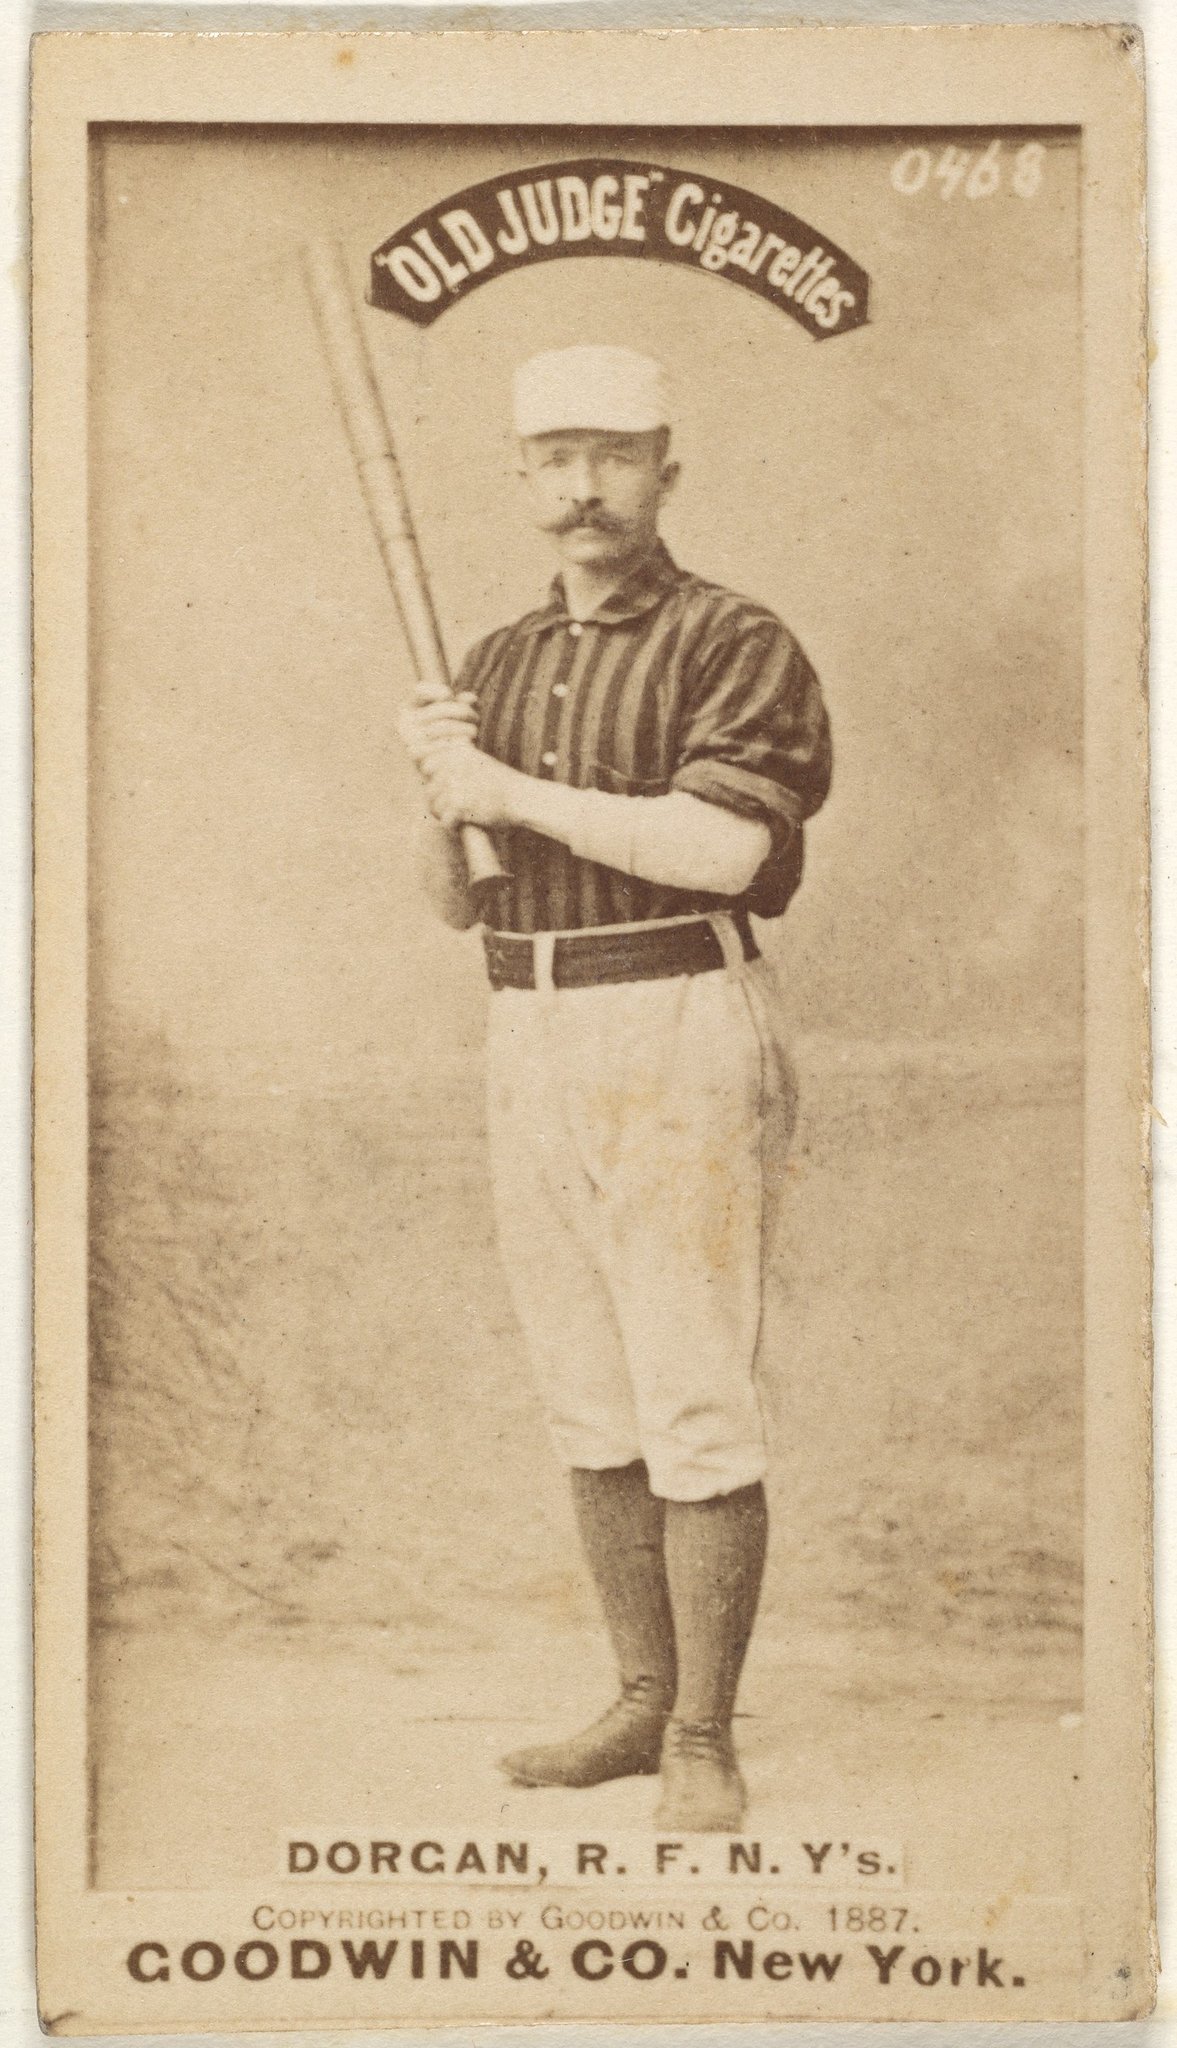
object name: baseball card, photograph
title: Michael Cornelius Dorgan, Right Field, New York, from the Old Judge series (N172) for Old Judge Cigarettes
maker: goodwin & company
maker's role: publisher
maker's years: 1850-1950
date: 1887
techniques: albumen silver print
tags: men,portraits,baseball,athletes